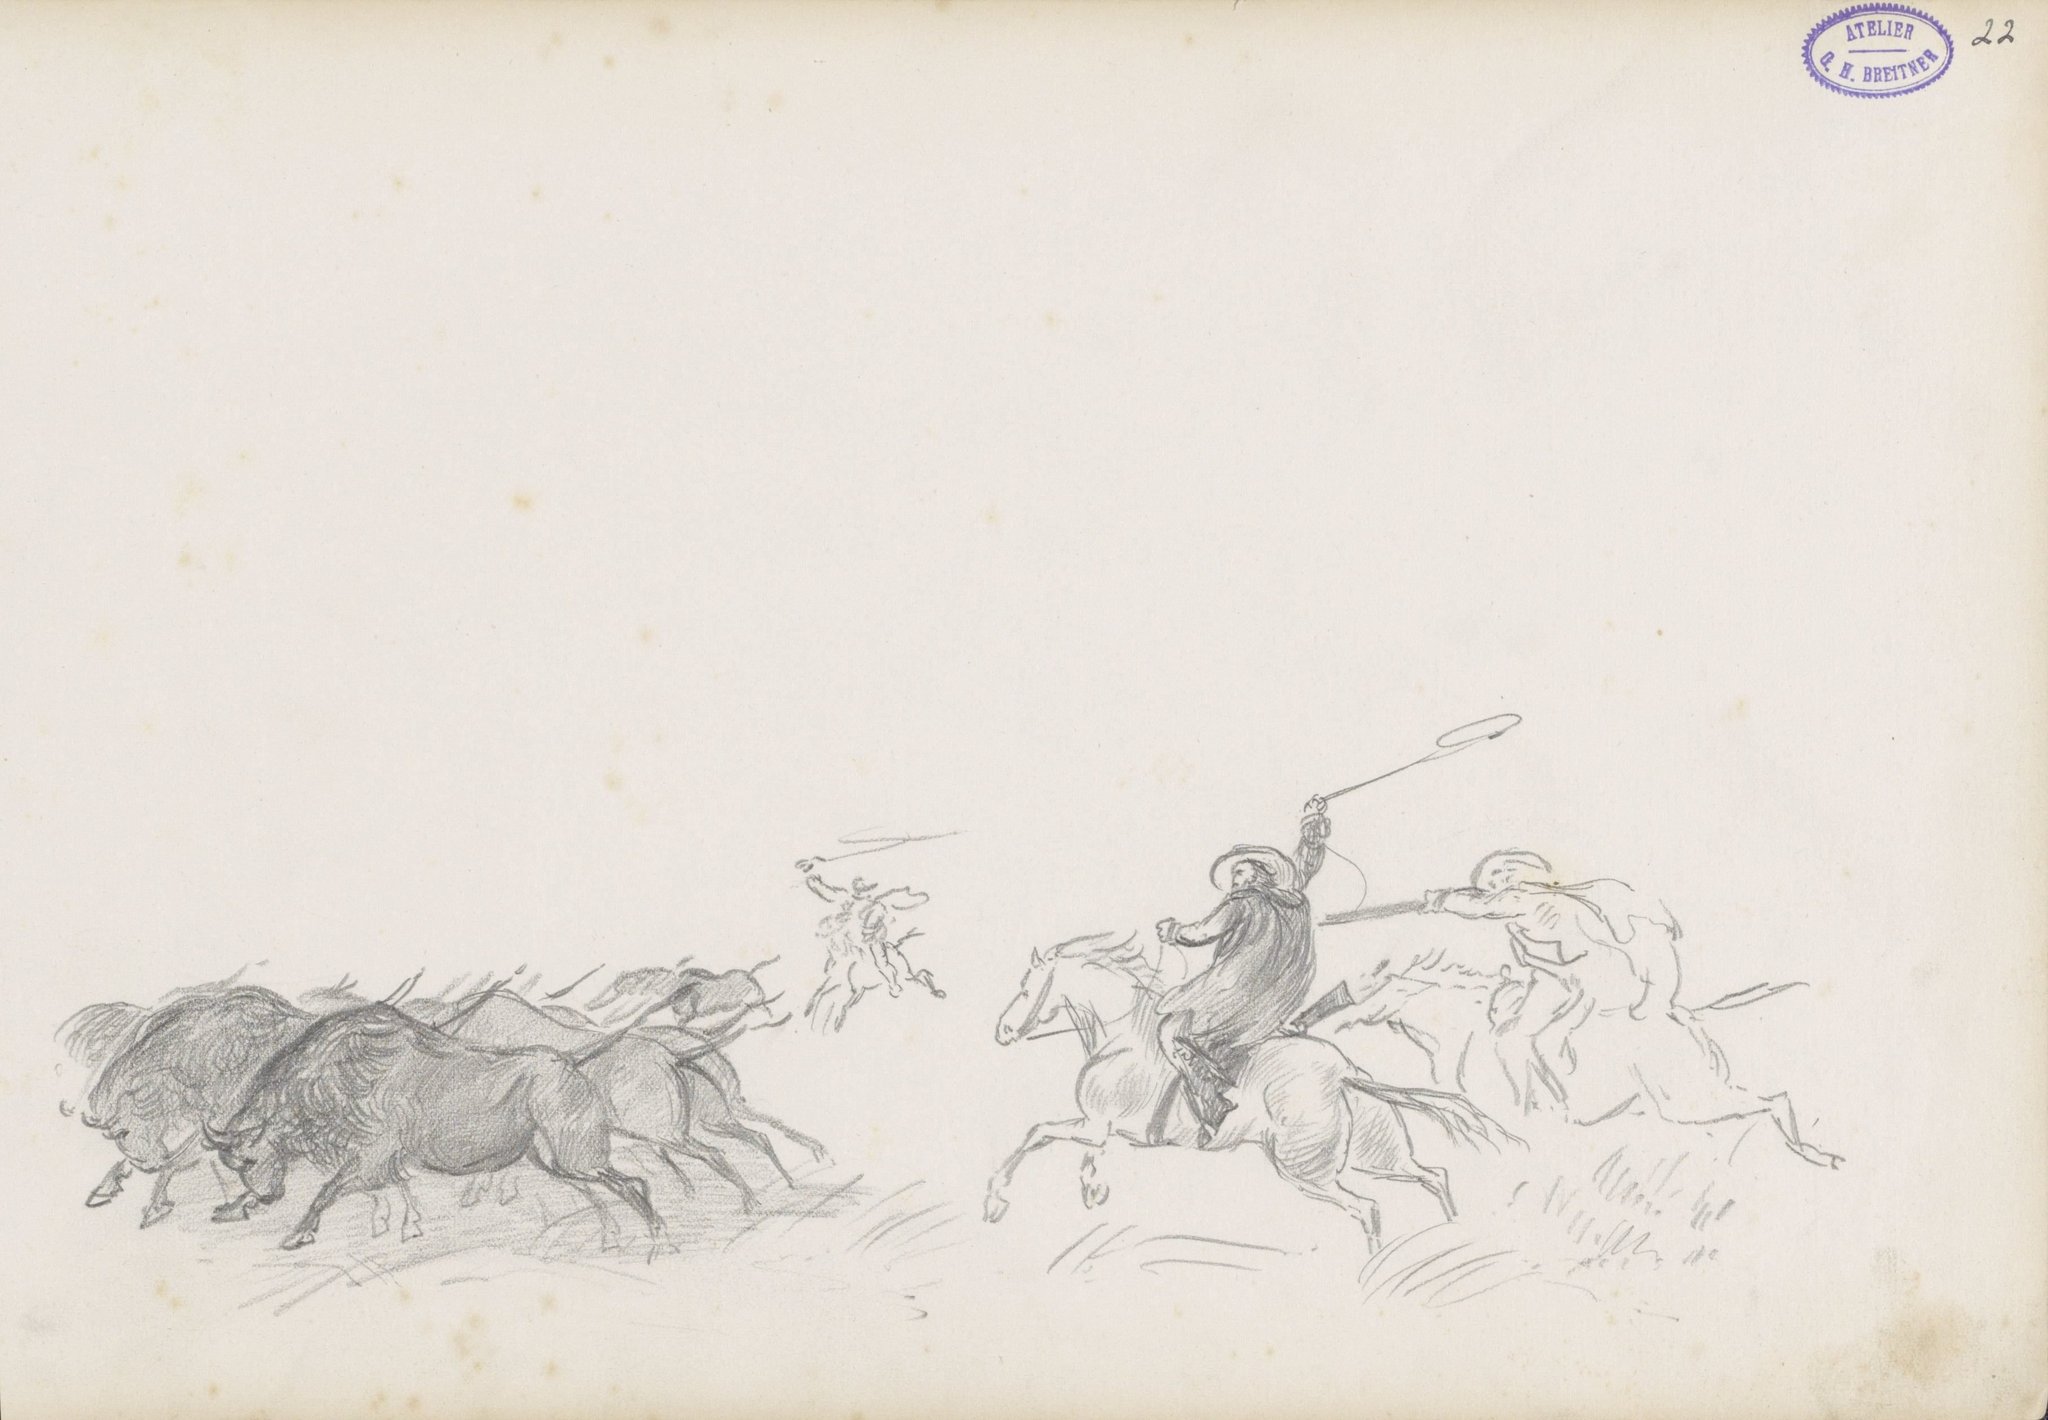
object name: drawing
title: Bisonjagers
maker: george hendrik breitner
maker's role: draughtsman, painter, print maker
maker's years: 1857-1923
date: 1872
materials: paper, pencil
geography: rotterdam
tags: hunters hunting (n.b.: in 1988-1990 this notation denoted the concept of 43c11421 'hunters resting during the hunt'), hoofed animals: bison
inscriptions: collector's mark: Lugt 2228, workshop stamp: Lugt 291d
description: Deze tekening heeft oorspronkelijk als blad 22 deel uitgemaakt van een schetsboek. Zie voor dit schetsboek het gerelateerd object.